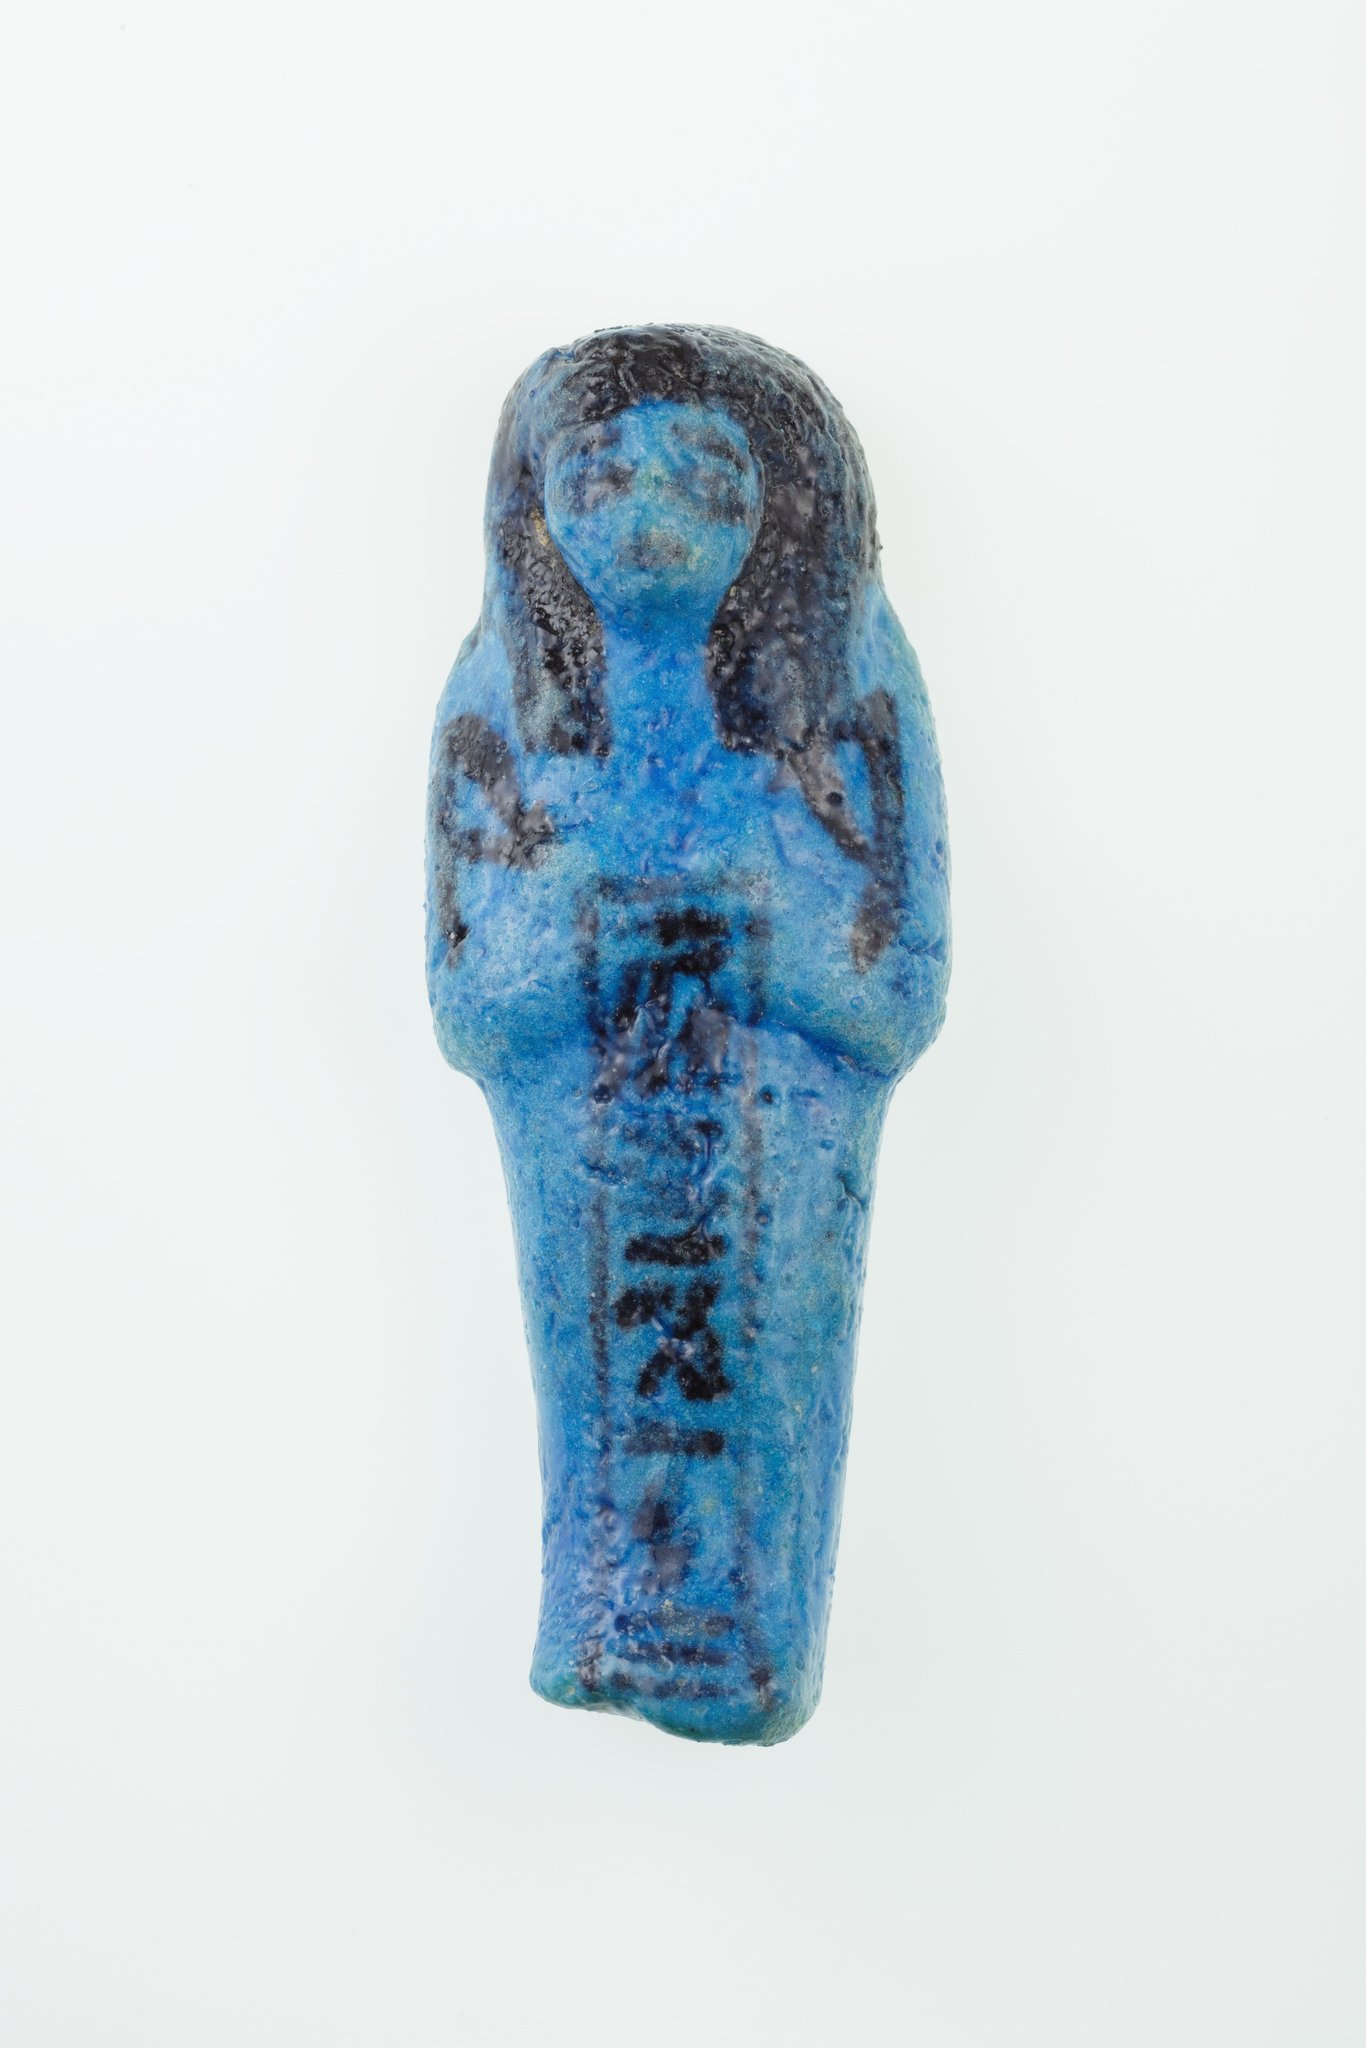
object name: shabti, worker, nauny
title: Worker Shabti of Nauny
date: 1050 BCE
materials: faience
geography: egypt